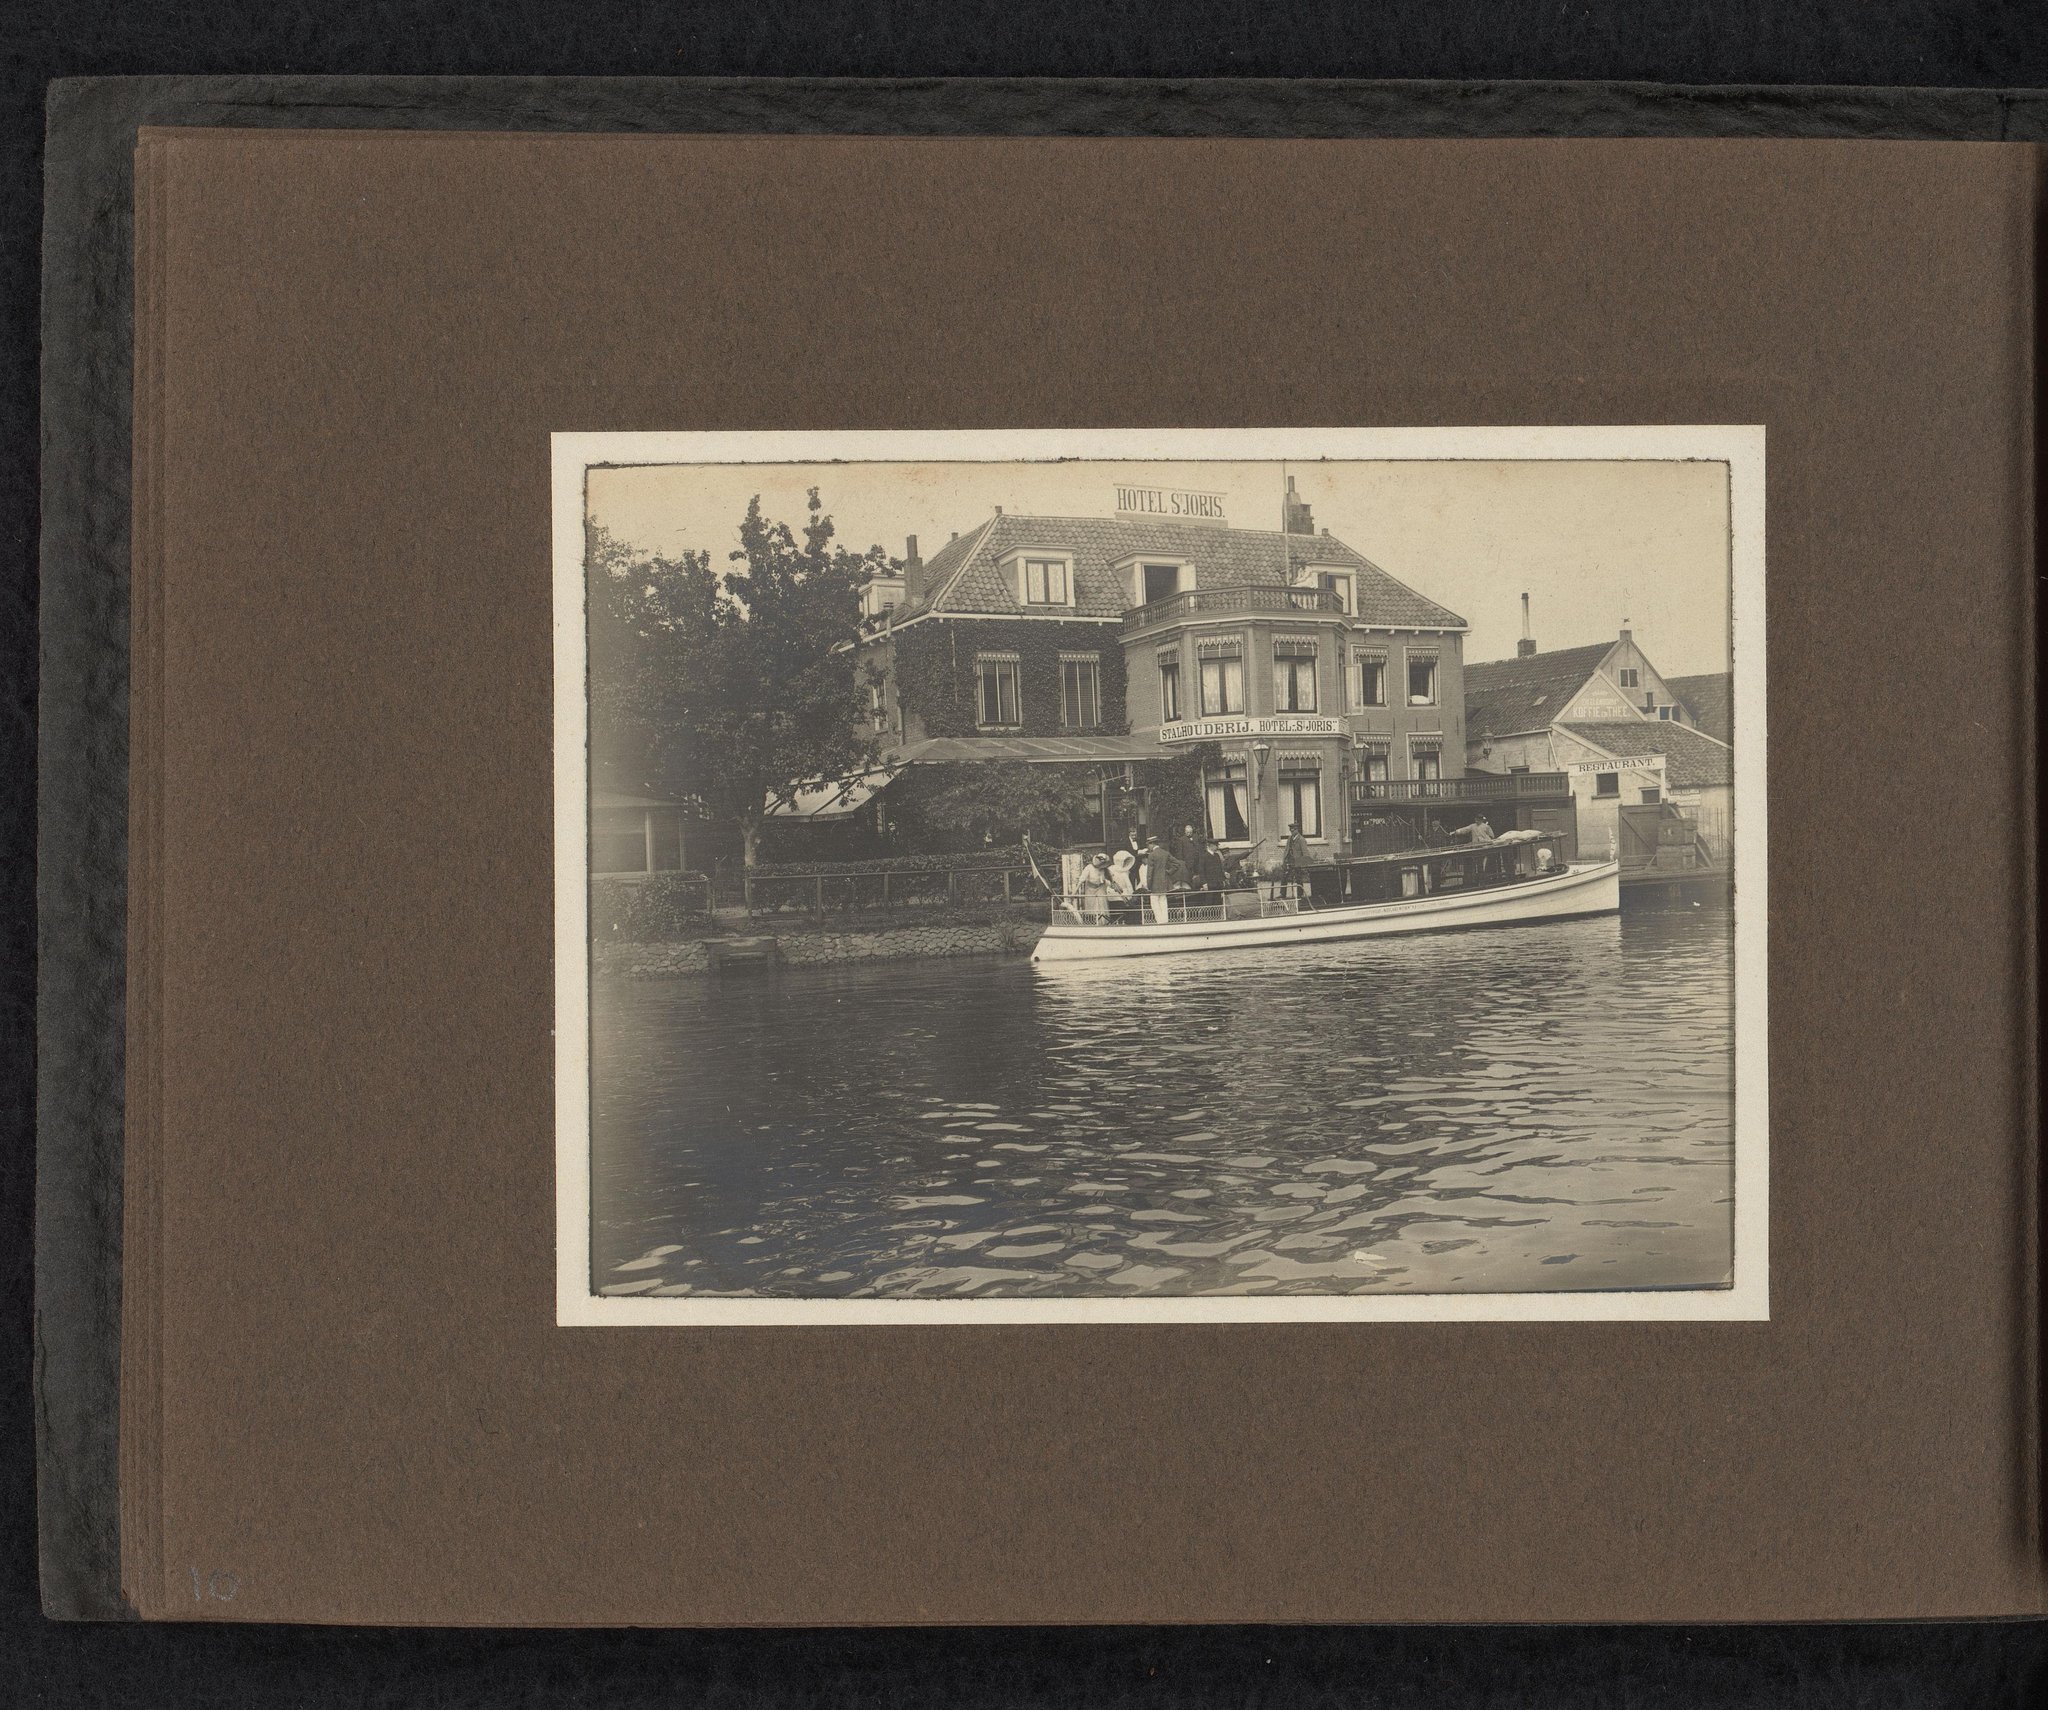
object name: album leaf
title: Gezicht op hotel Sint Joris vanaf de Oude Rijn bij Alphen aan den Rijn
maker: hendrik herman van den berg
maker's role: amateurfotograaf, jurist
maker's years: 1875-1944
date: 1908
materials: paper, cardboard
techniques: gelatin silver print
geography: alphen aan den rijn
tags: river, hotel, hostelry, inn